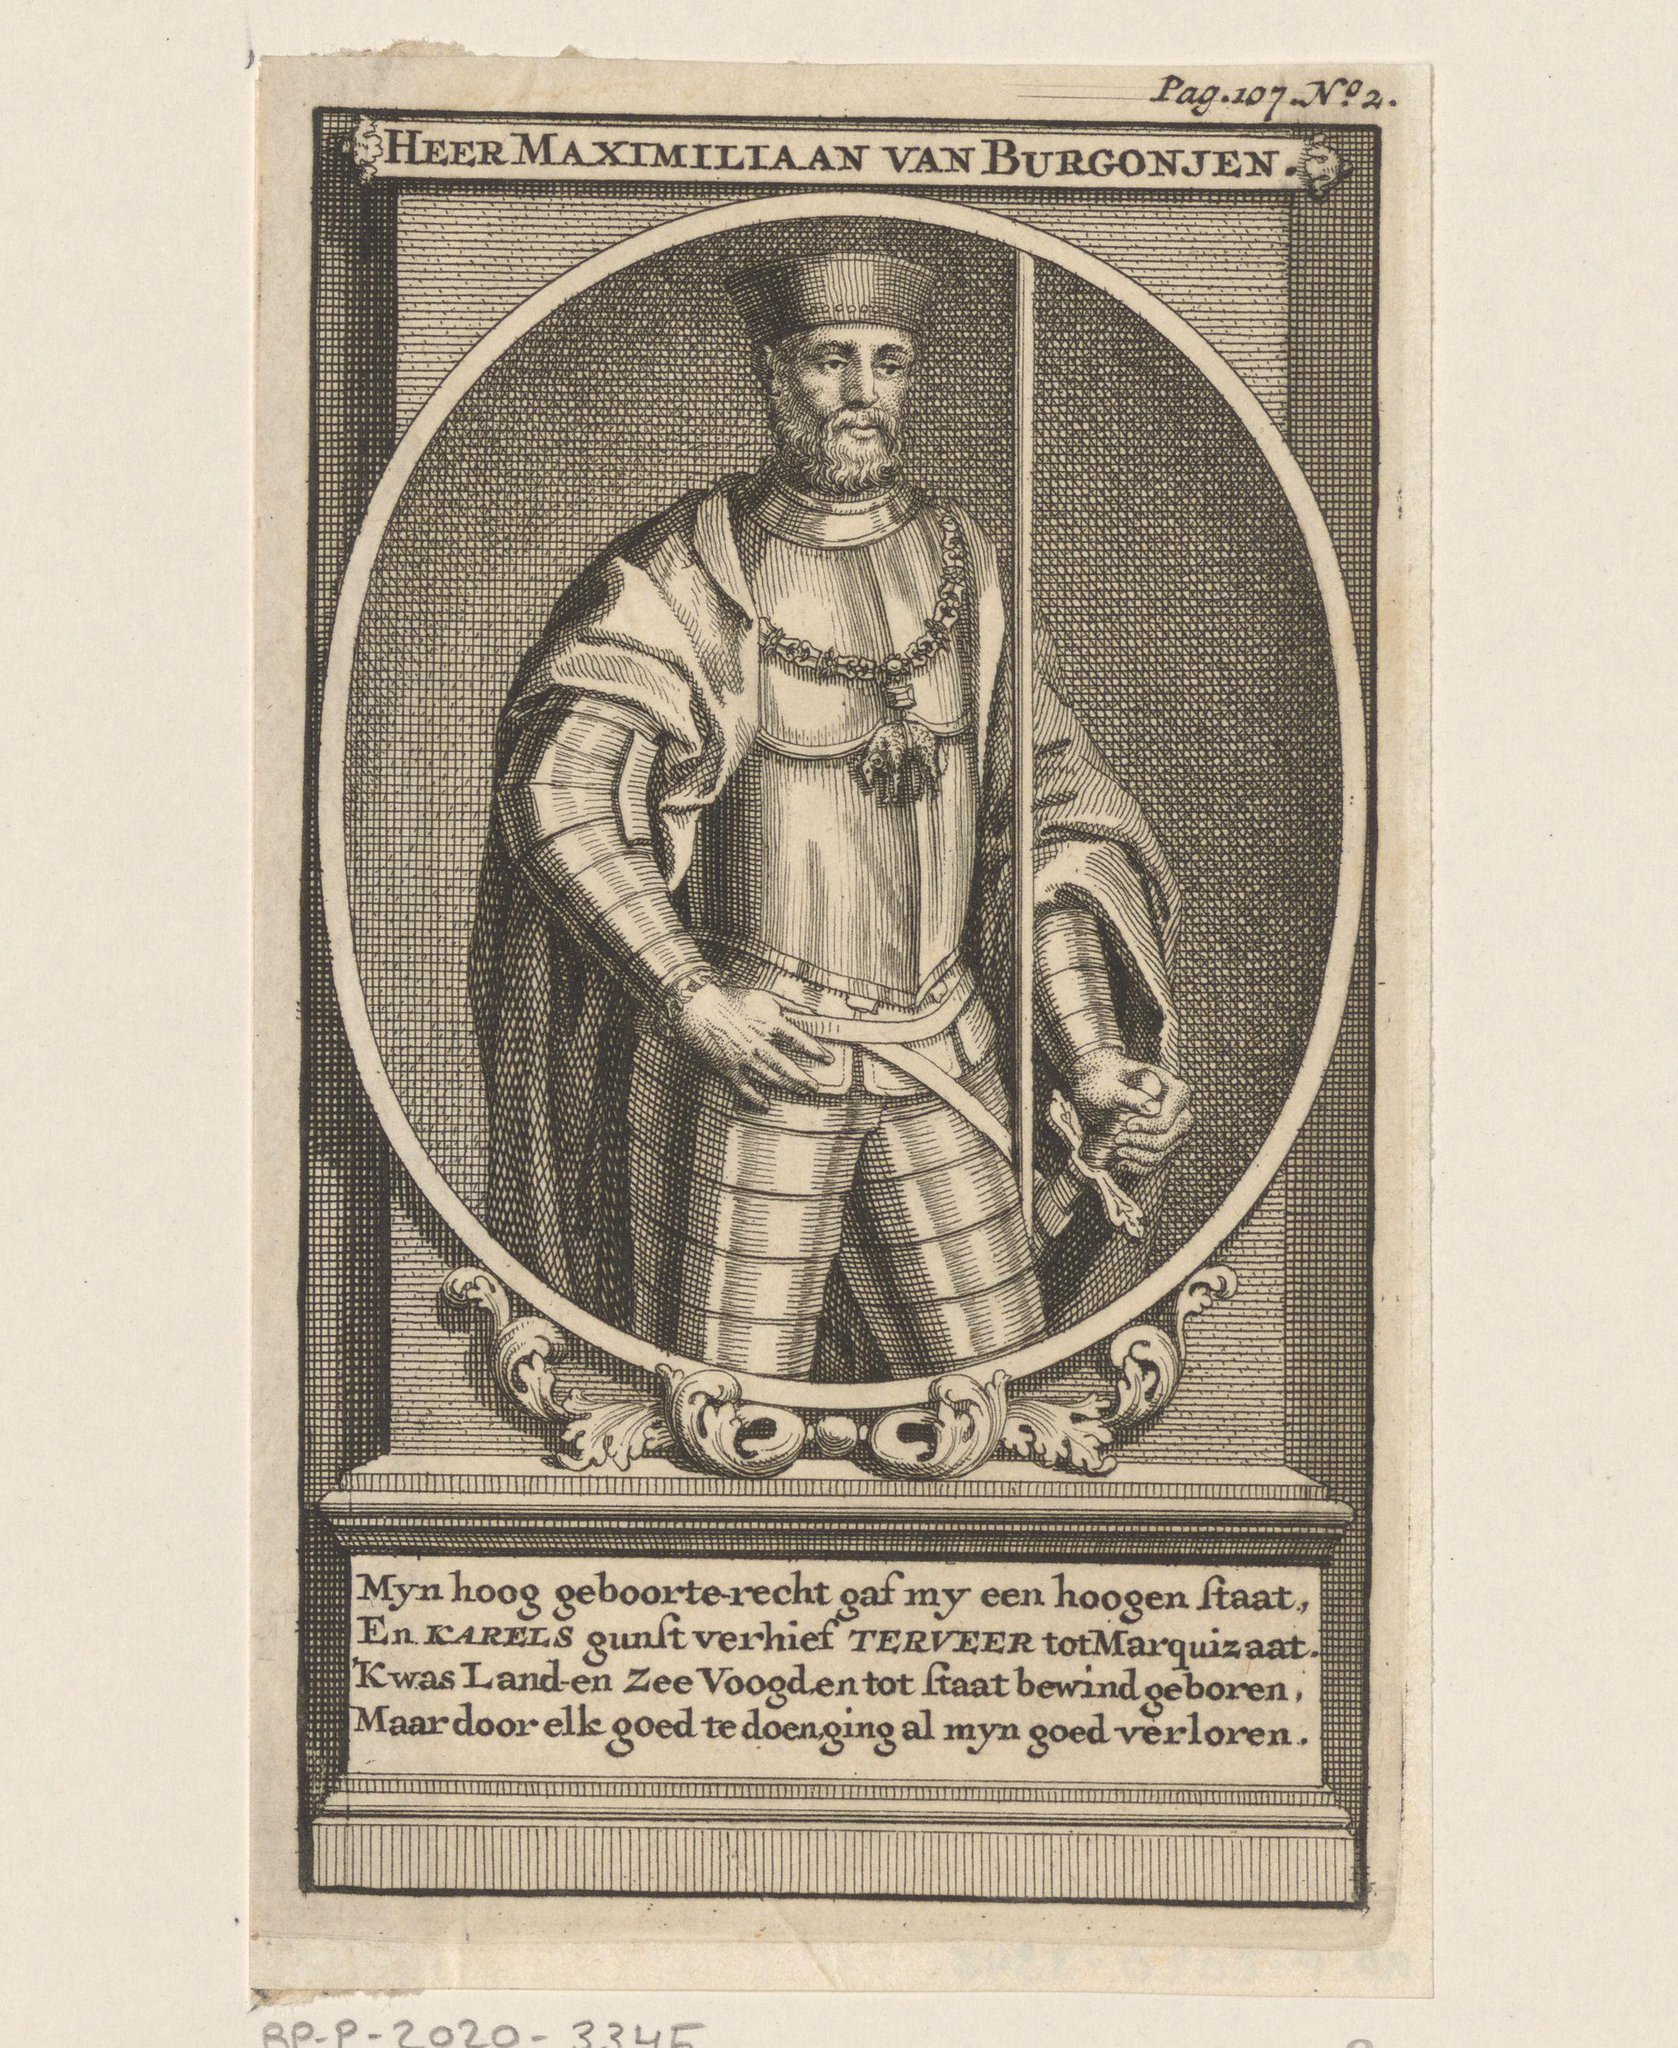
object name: book illustration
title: Portret van Filips van Bourgondië-Beveren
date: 1717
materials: paper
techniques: engraving, etching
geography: leiden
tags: armour, historical persons, knighthood order of the golden fleece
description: Prent uit: Gargon, Mattheus. Walchersche Arkadia. Leiden: Samuel Luchtmans, 1717. Prent met andere nummering gebruikt in latere edities van dit werk. Prent mogelijk ook in andere publicaties gebruikt.